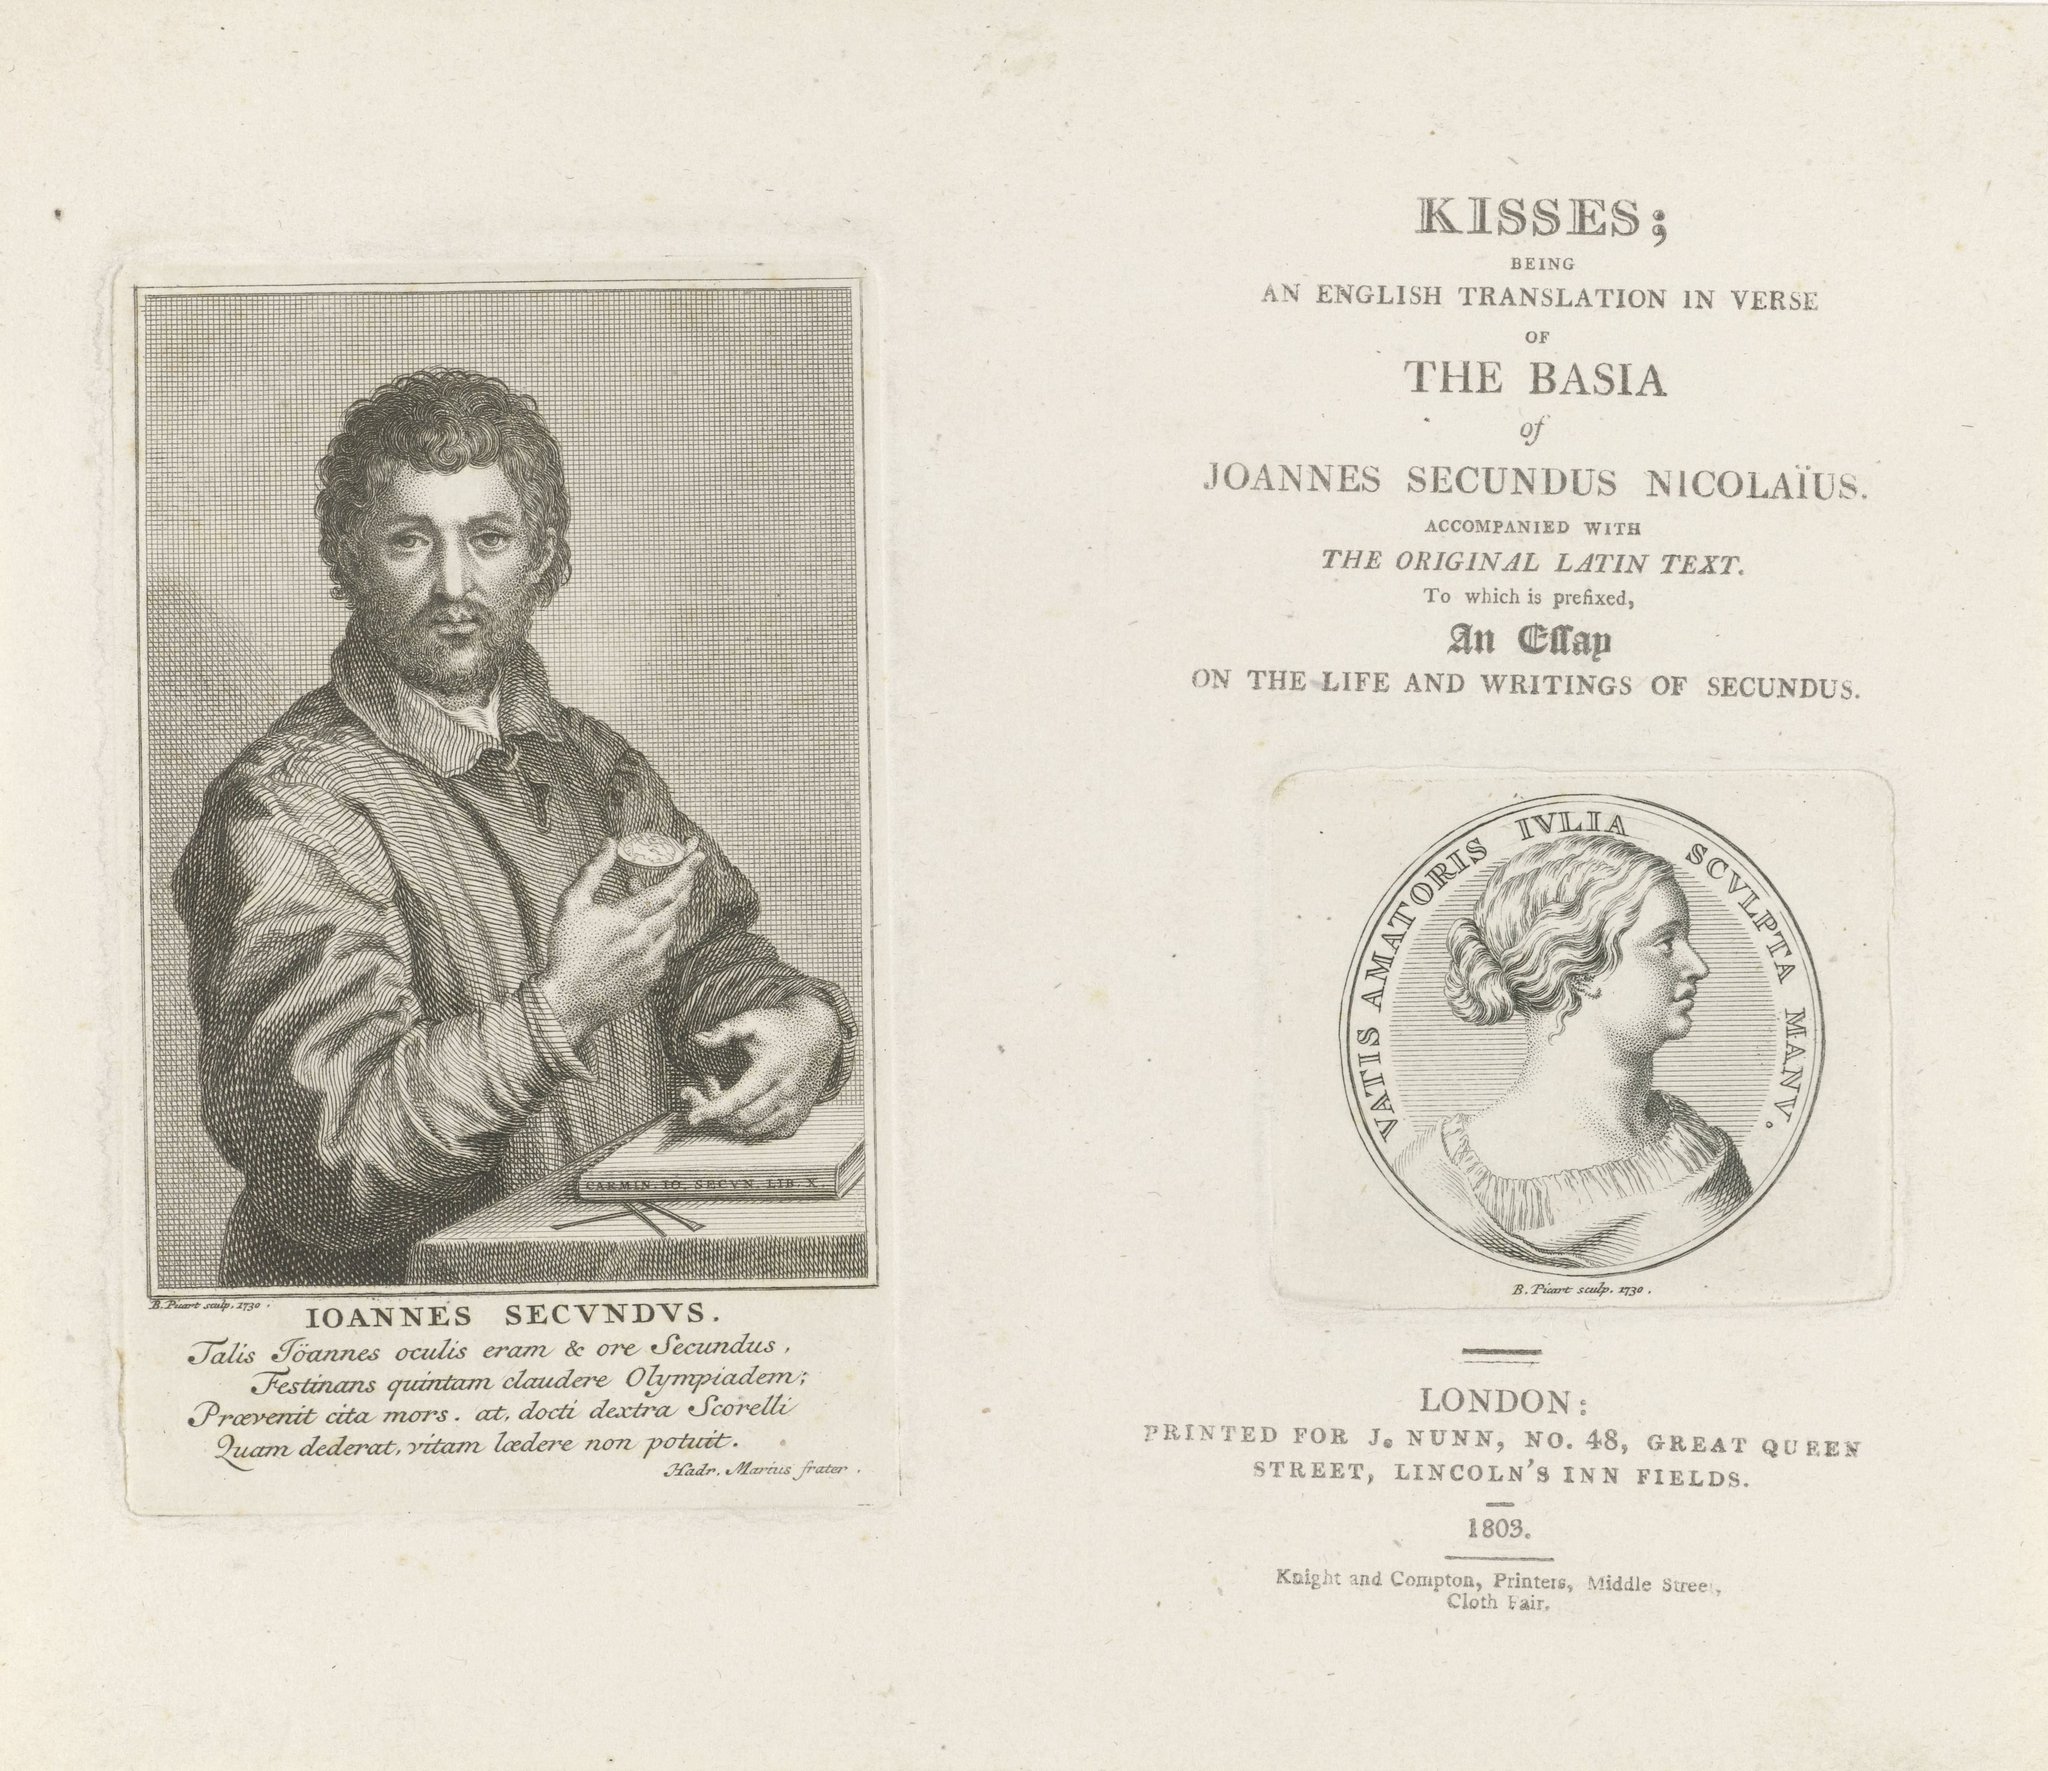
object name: print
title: Portret van Janus Secundus en medaillon met het portret van Julia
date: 1730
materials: paper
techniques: engraving, etching, letterpress printing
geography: amsterdam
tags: the hague, janus secundus, historical persons, portrait of a writer, medal (considered as a piece of sculpture, regardless of its specific function)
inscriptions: collector's mark: Lugt 2228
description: Titelpagina met het portret van de schrijver Janus Secundus. In zijn hand houdt hij een medaillon met het portret van Julia, zijn eerste grote liefde, over wie hij dit liefdeselegie schreef. Rechts de titel en het impressum in het Engels en het medaillon met het portret van Julia.